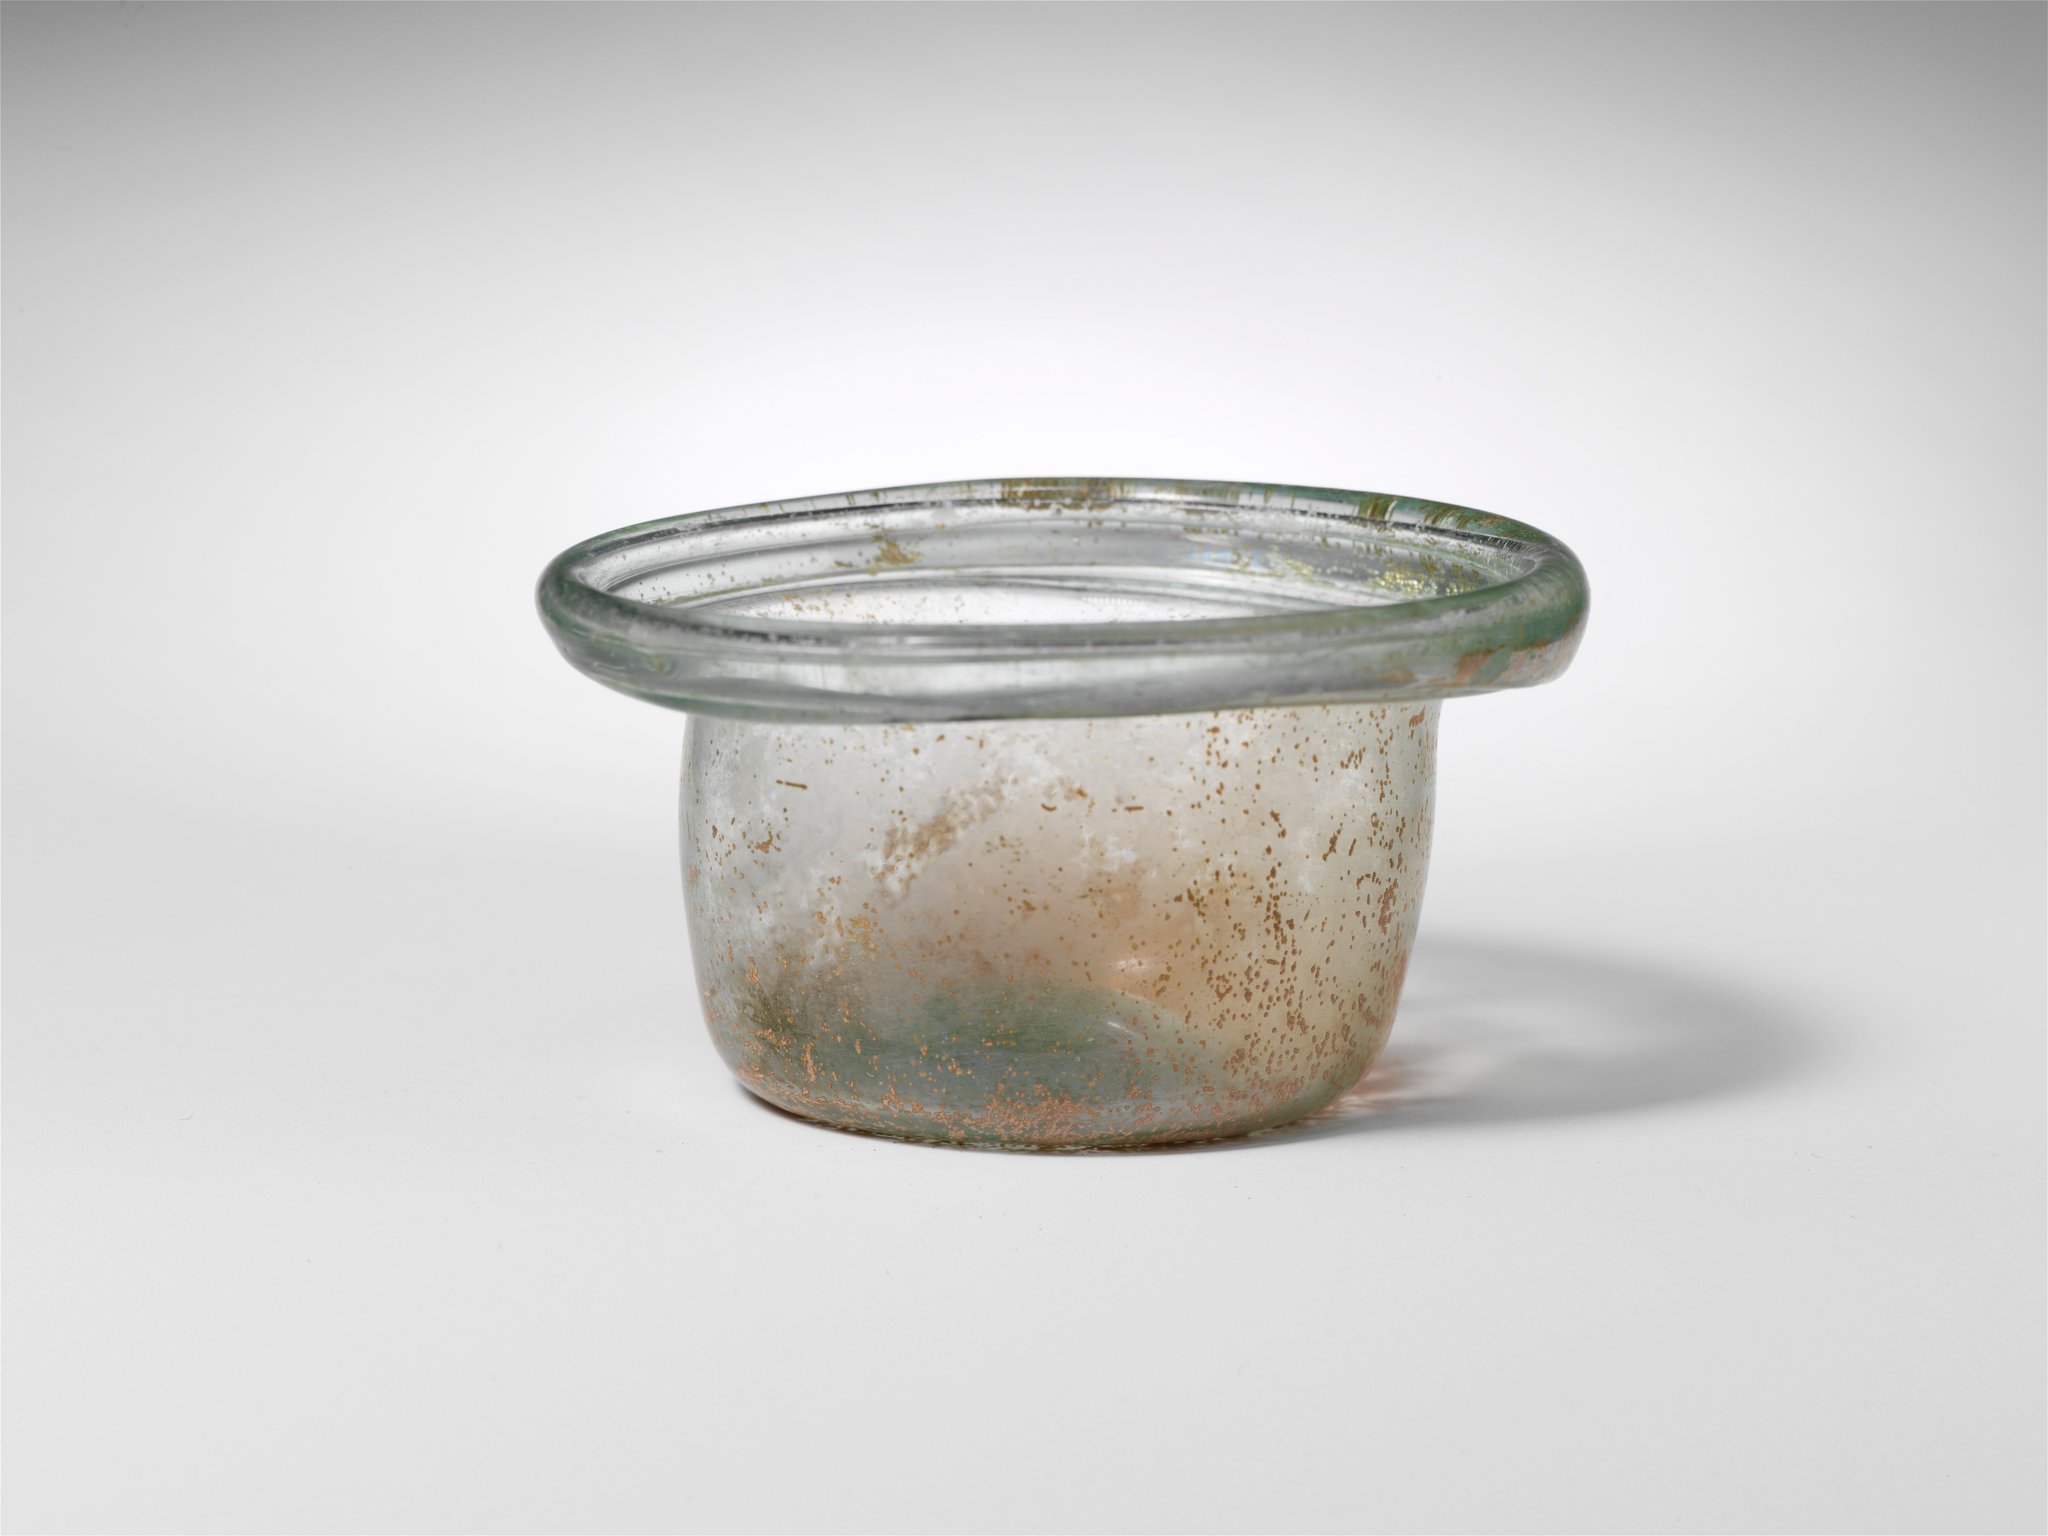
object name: jar or bowl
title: Glass bowl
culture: roman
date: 201-300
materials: glass